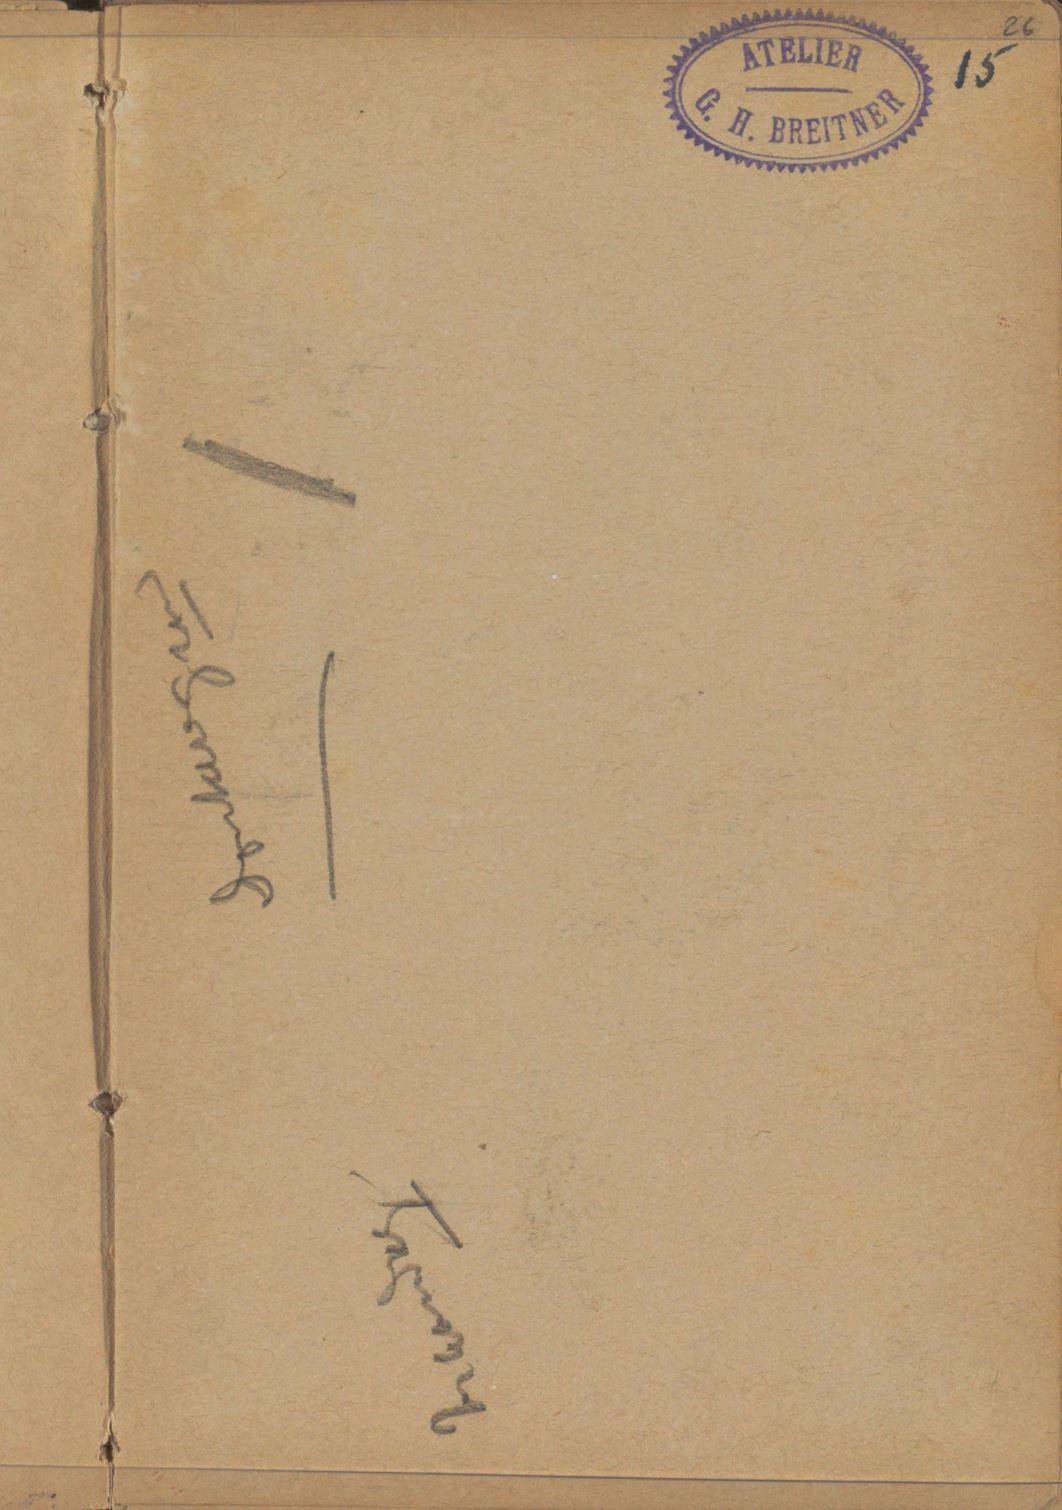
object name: sketchbook leaf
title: Studie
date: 1887-1891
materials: paper, pencil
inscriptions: annotation: ‘maandag’, : ‘donkergroen’, workshop stamp: Lugt 291d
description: Pagina 26 uit een schetsboek met 83 bladen.